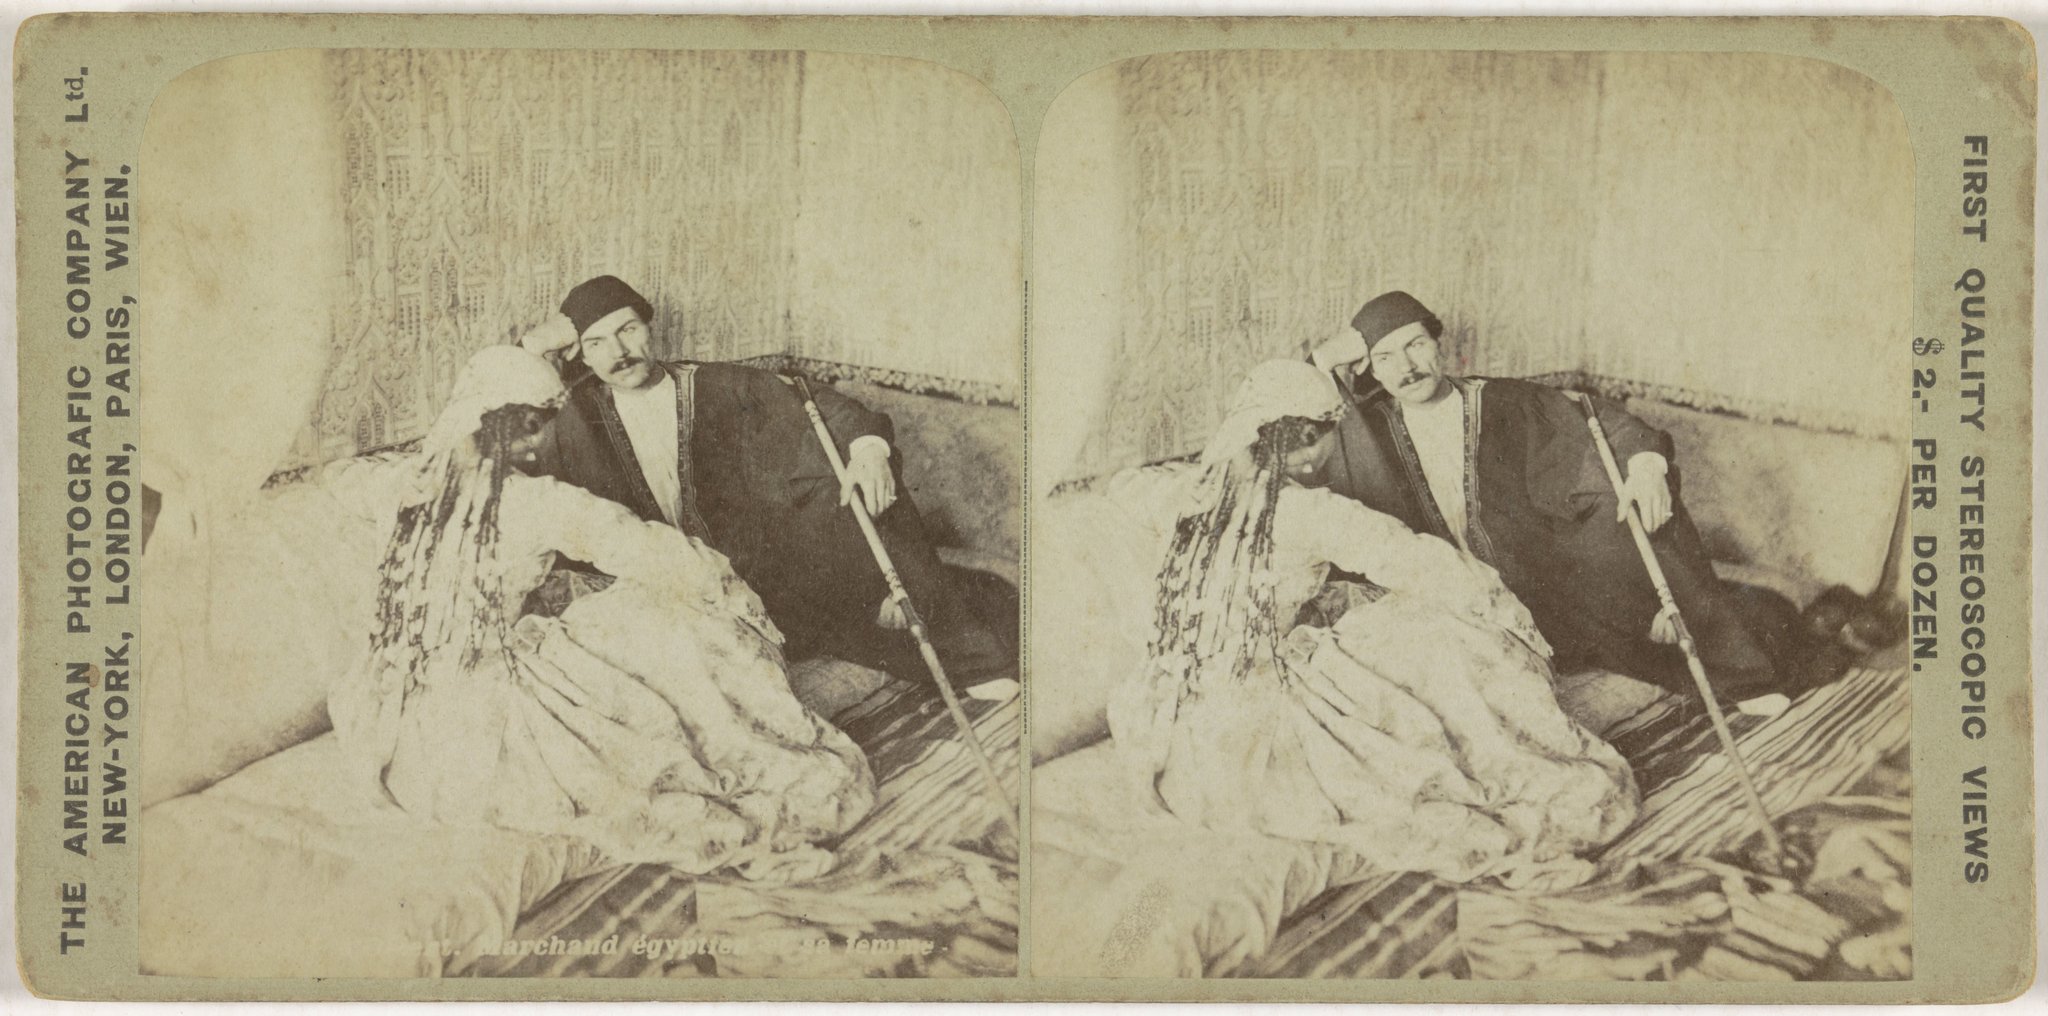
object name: stereograph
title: Types d'Orient. Marchand égyptien et sa femme.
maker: Anonymous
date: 1860-1870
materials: cardboard, paper, photographic support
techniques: gelatin silver print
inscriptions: number: ‘20 / 00000’